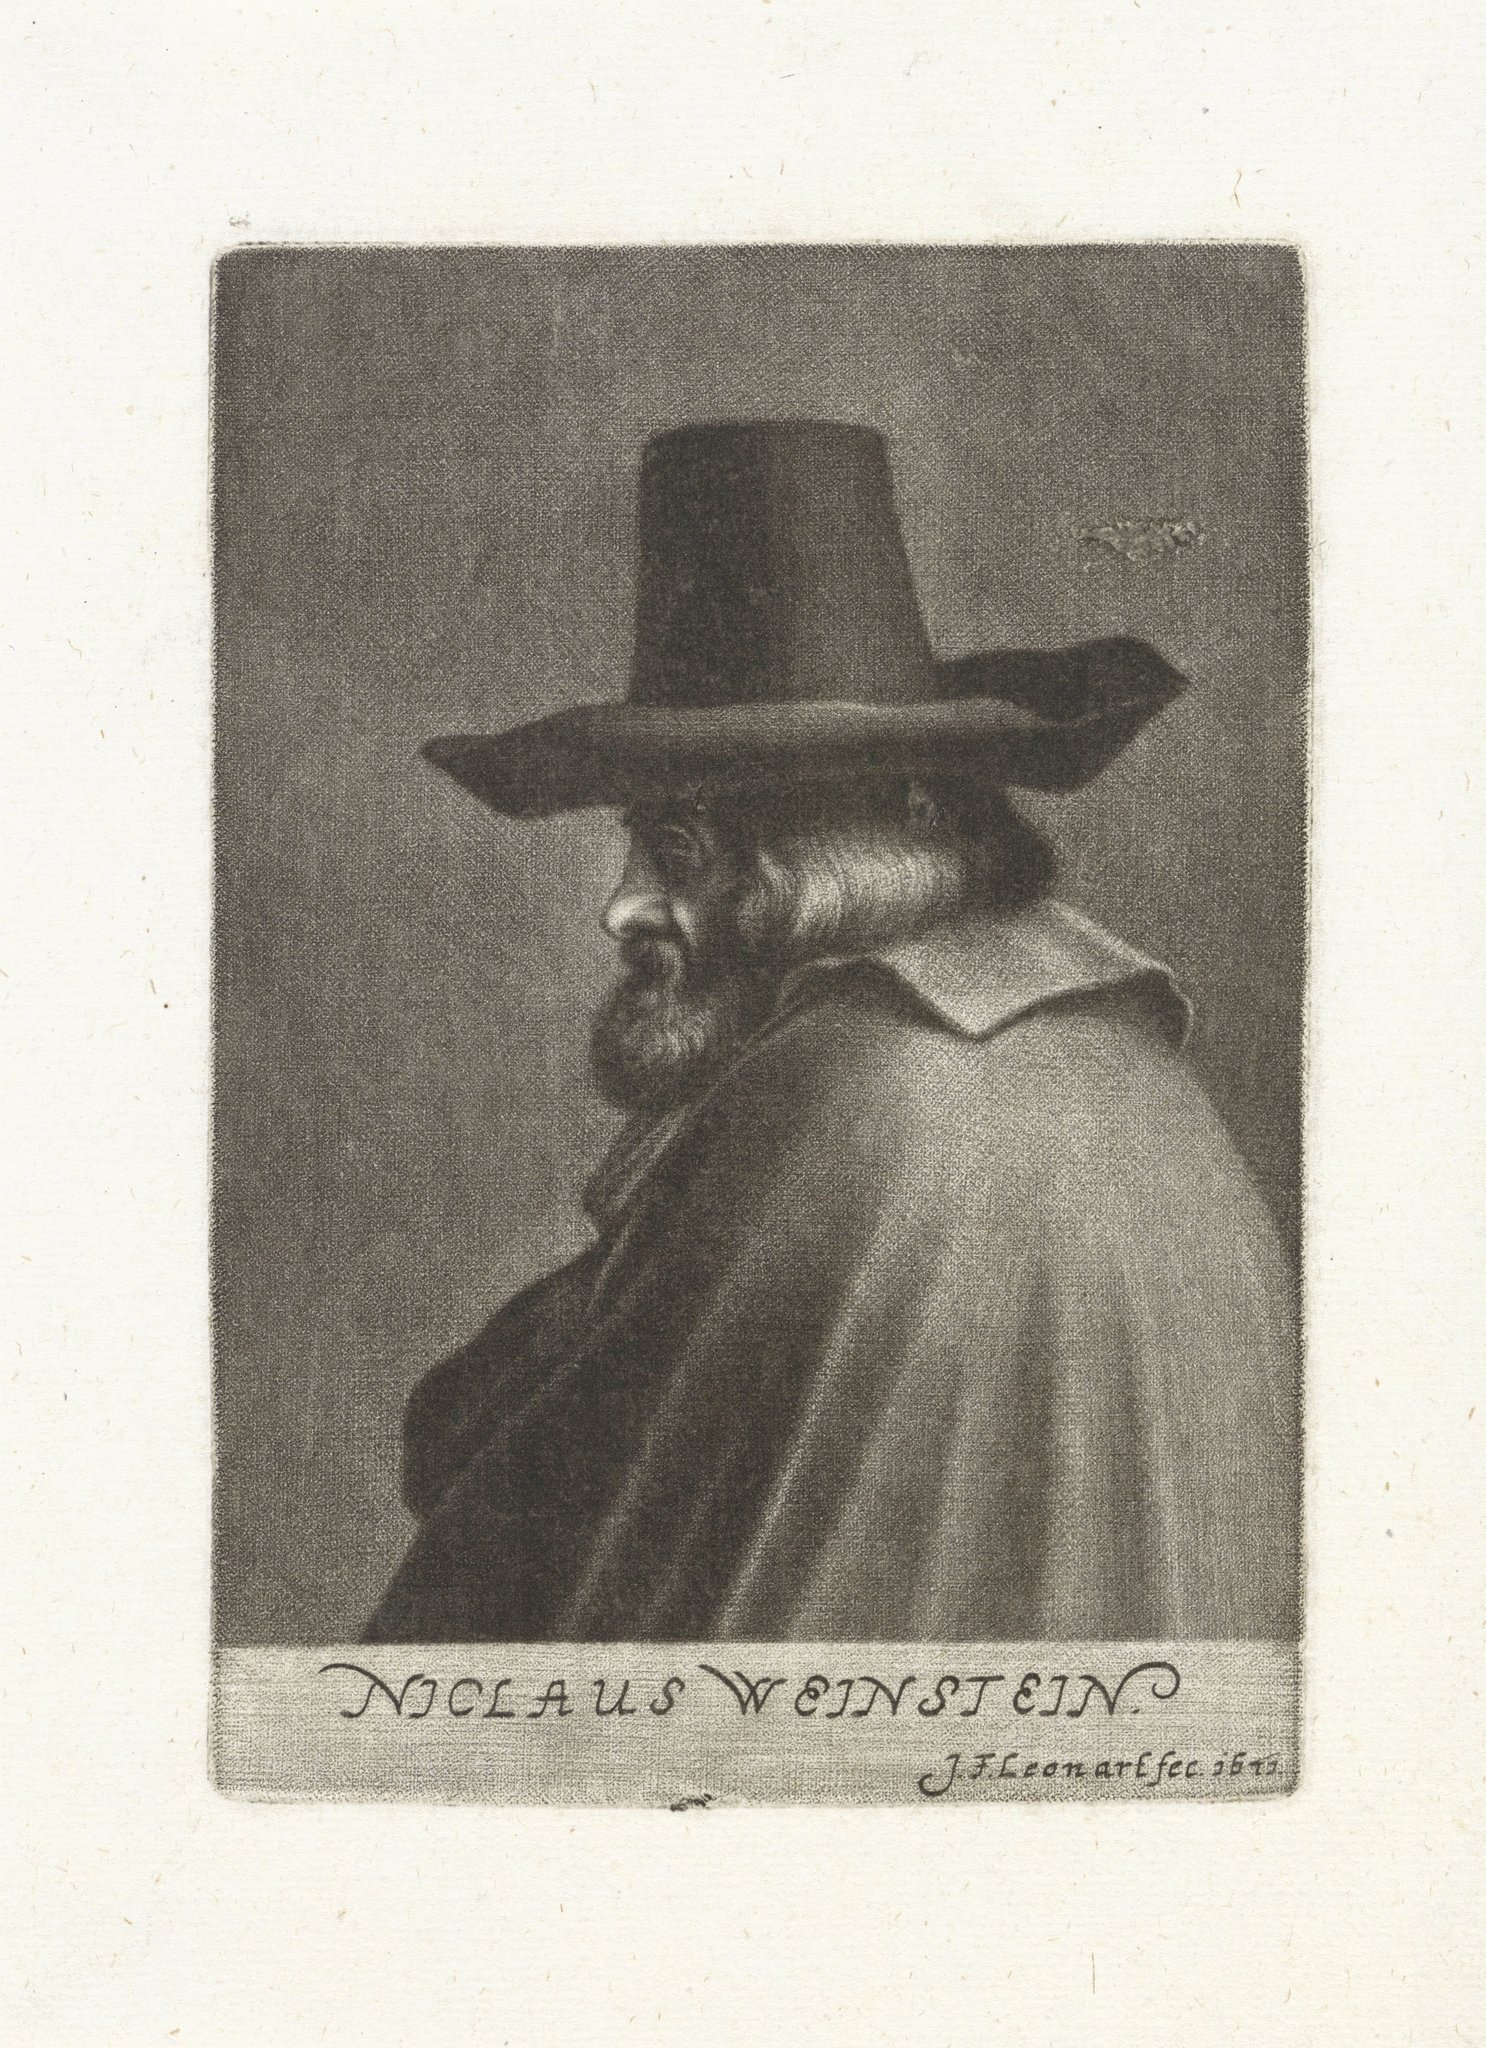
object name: print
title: Portret van Niclaus Weinstein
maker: johann friedrich leonard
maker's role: print maker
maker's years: 1633-1680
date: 1671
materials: paper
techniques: mezzotint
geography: prague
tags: head-gear: hat (+ men's clothes)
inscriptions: collector's mark: Lugt 2166